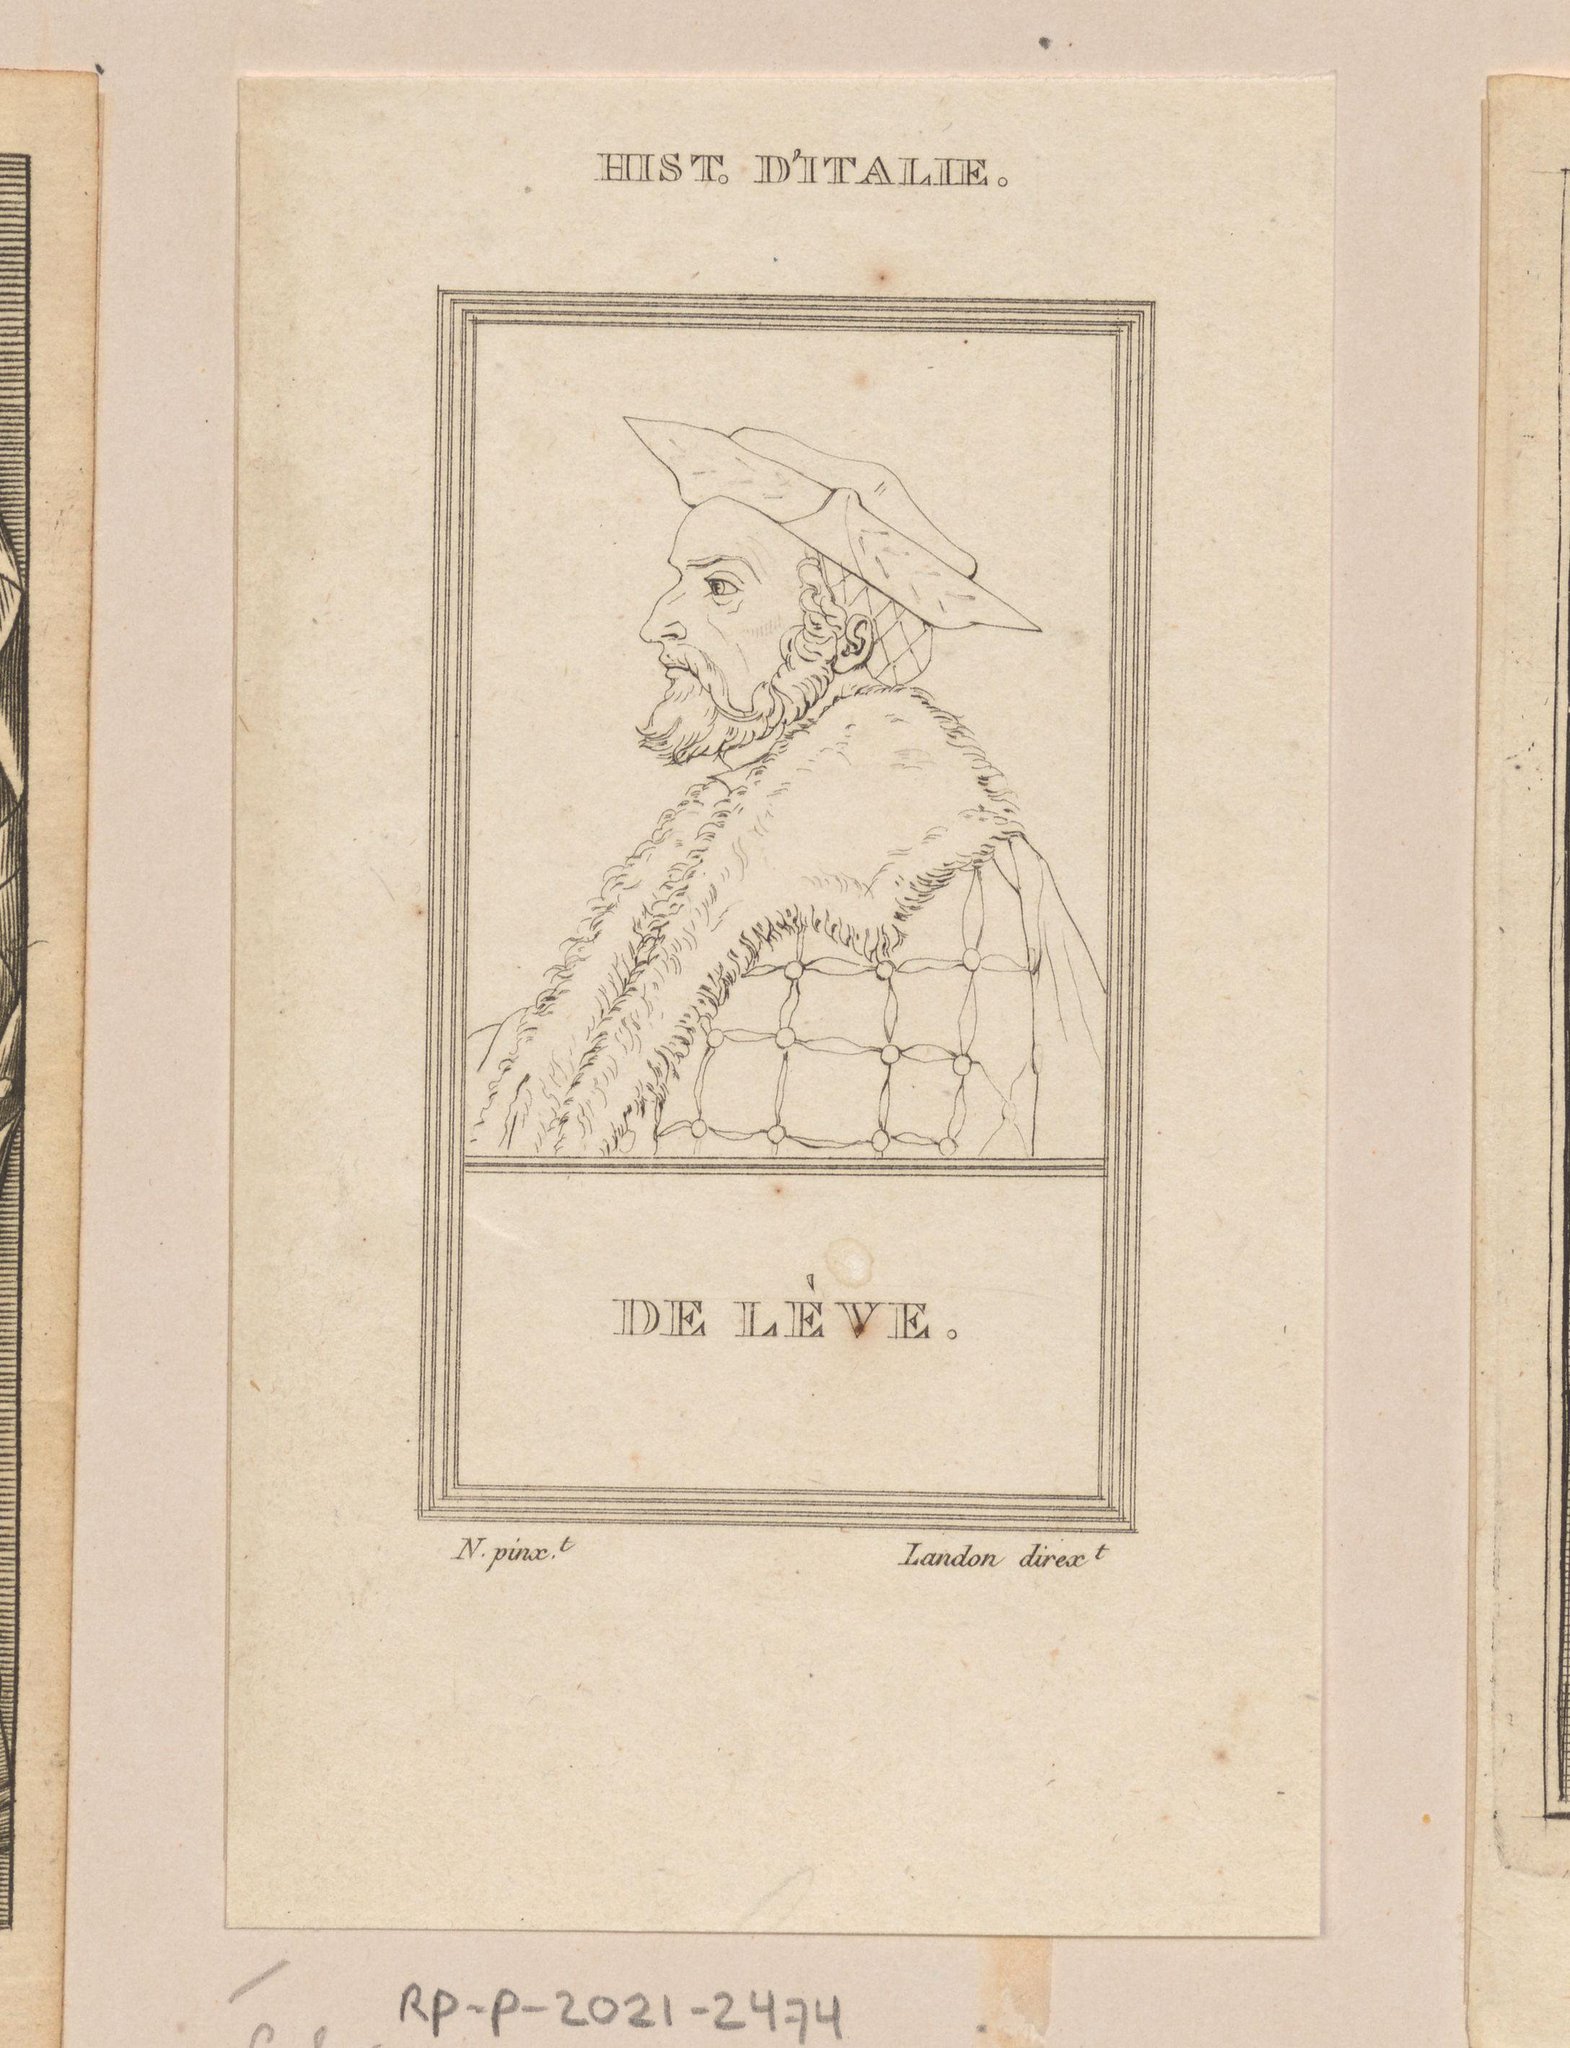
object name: print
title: Portret van Antonio de Leyva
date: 1808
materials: paper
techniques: etching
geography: france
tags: commander-in-chief, general, marshal, historical persons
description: Prent waarschijnlijk uit: Galerie historique des hommes les plus celebres de tous les nations (...). Parijs: Charles Paul Landon, 1808, dl. 11.